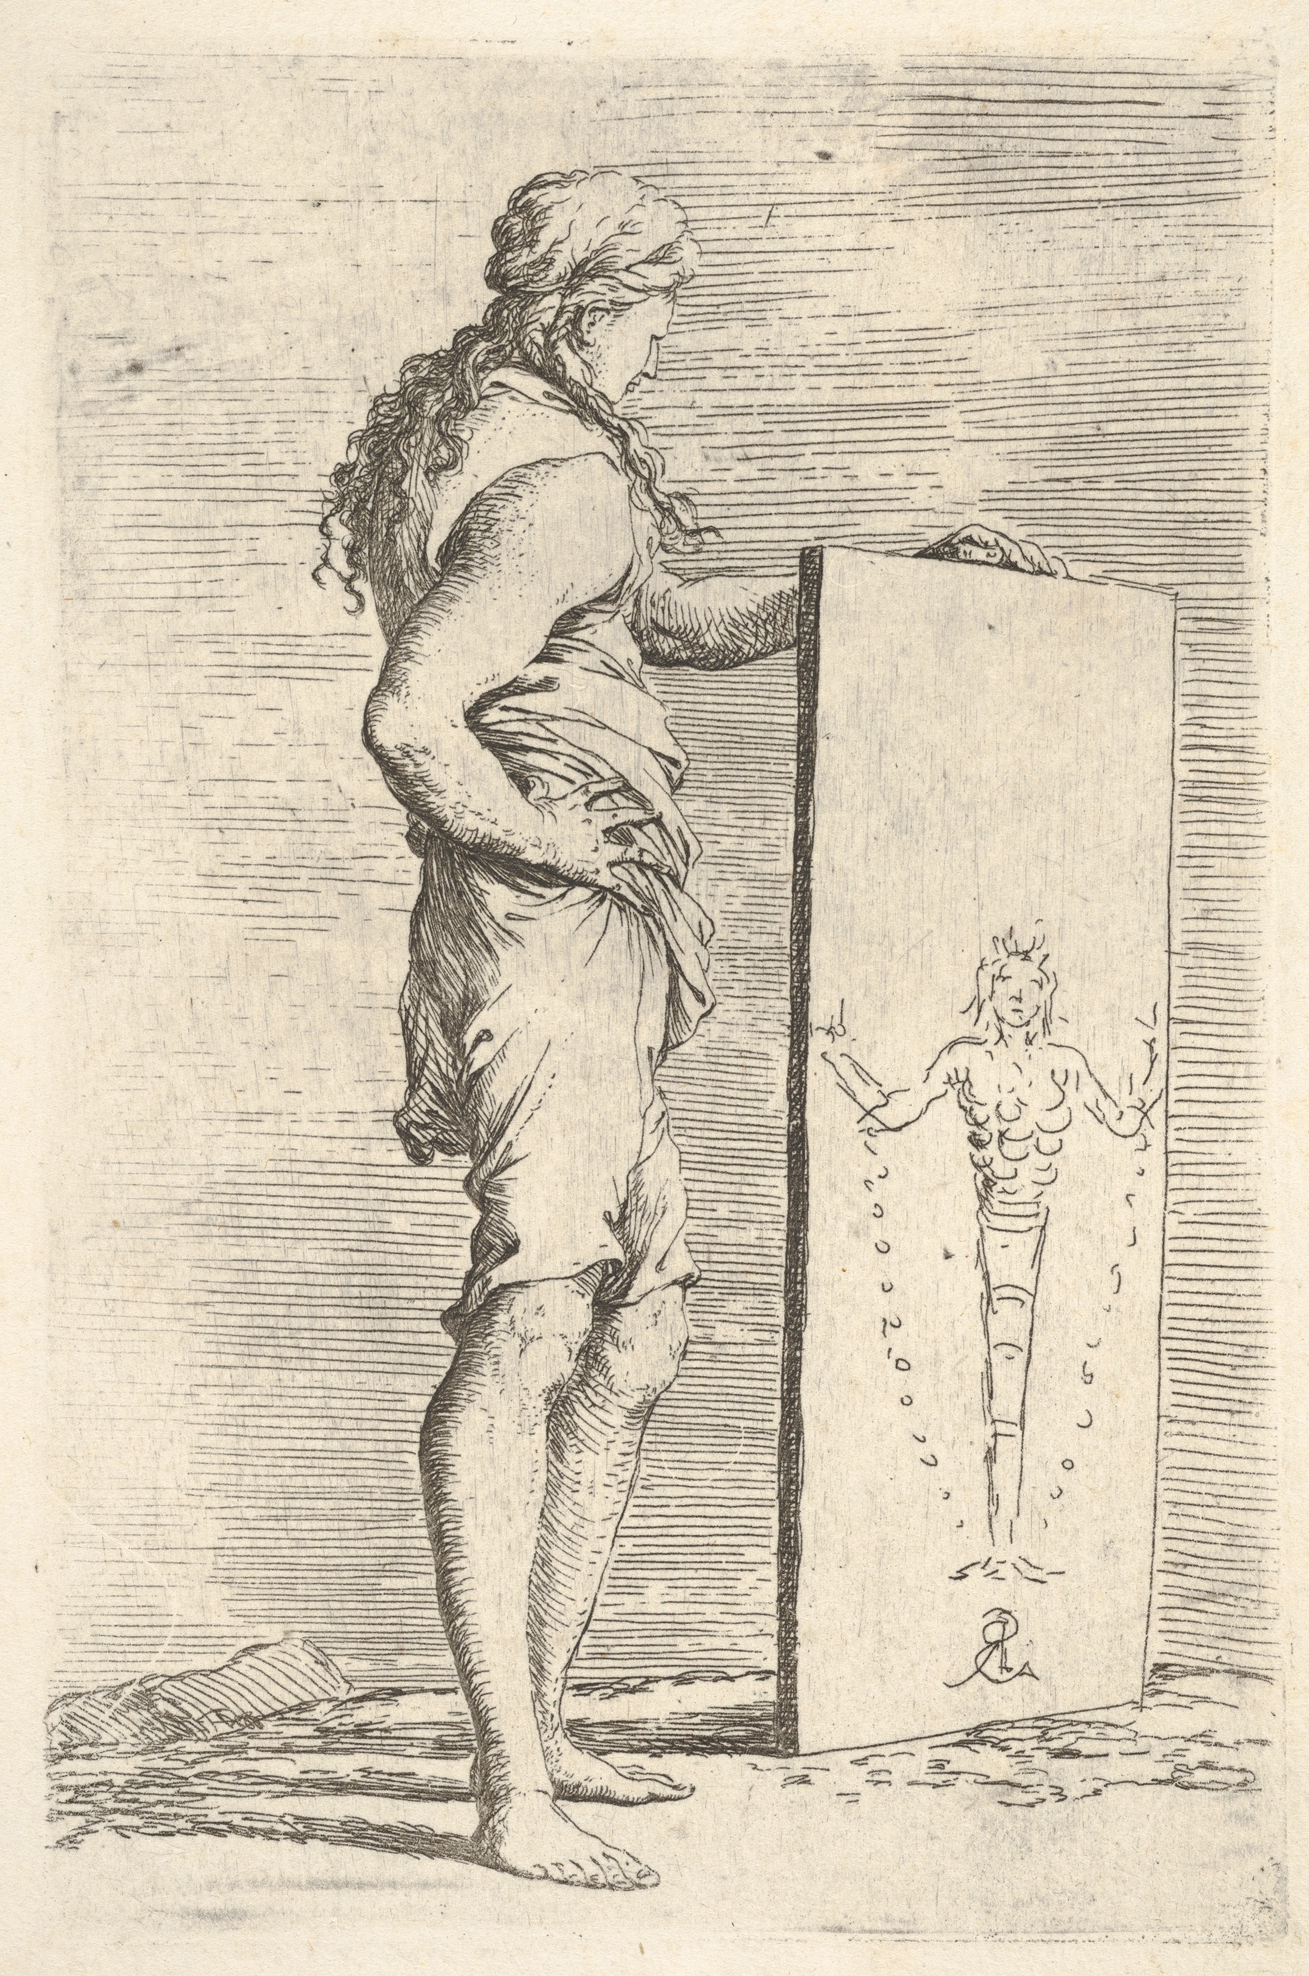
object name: print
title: A figure supporting a tablet with a representation of a herm of Diana of Ephesus, from "Figurine"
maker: salvator rosa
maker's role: artist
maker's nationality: italian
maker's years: 1615-1673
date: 1656-1657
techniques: etching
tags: tablets,men